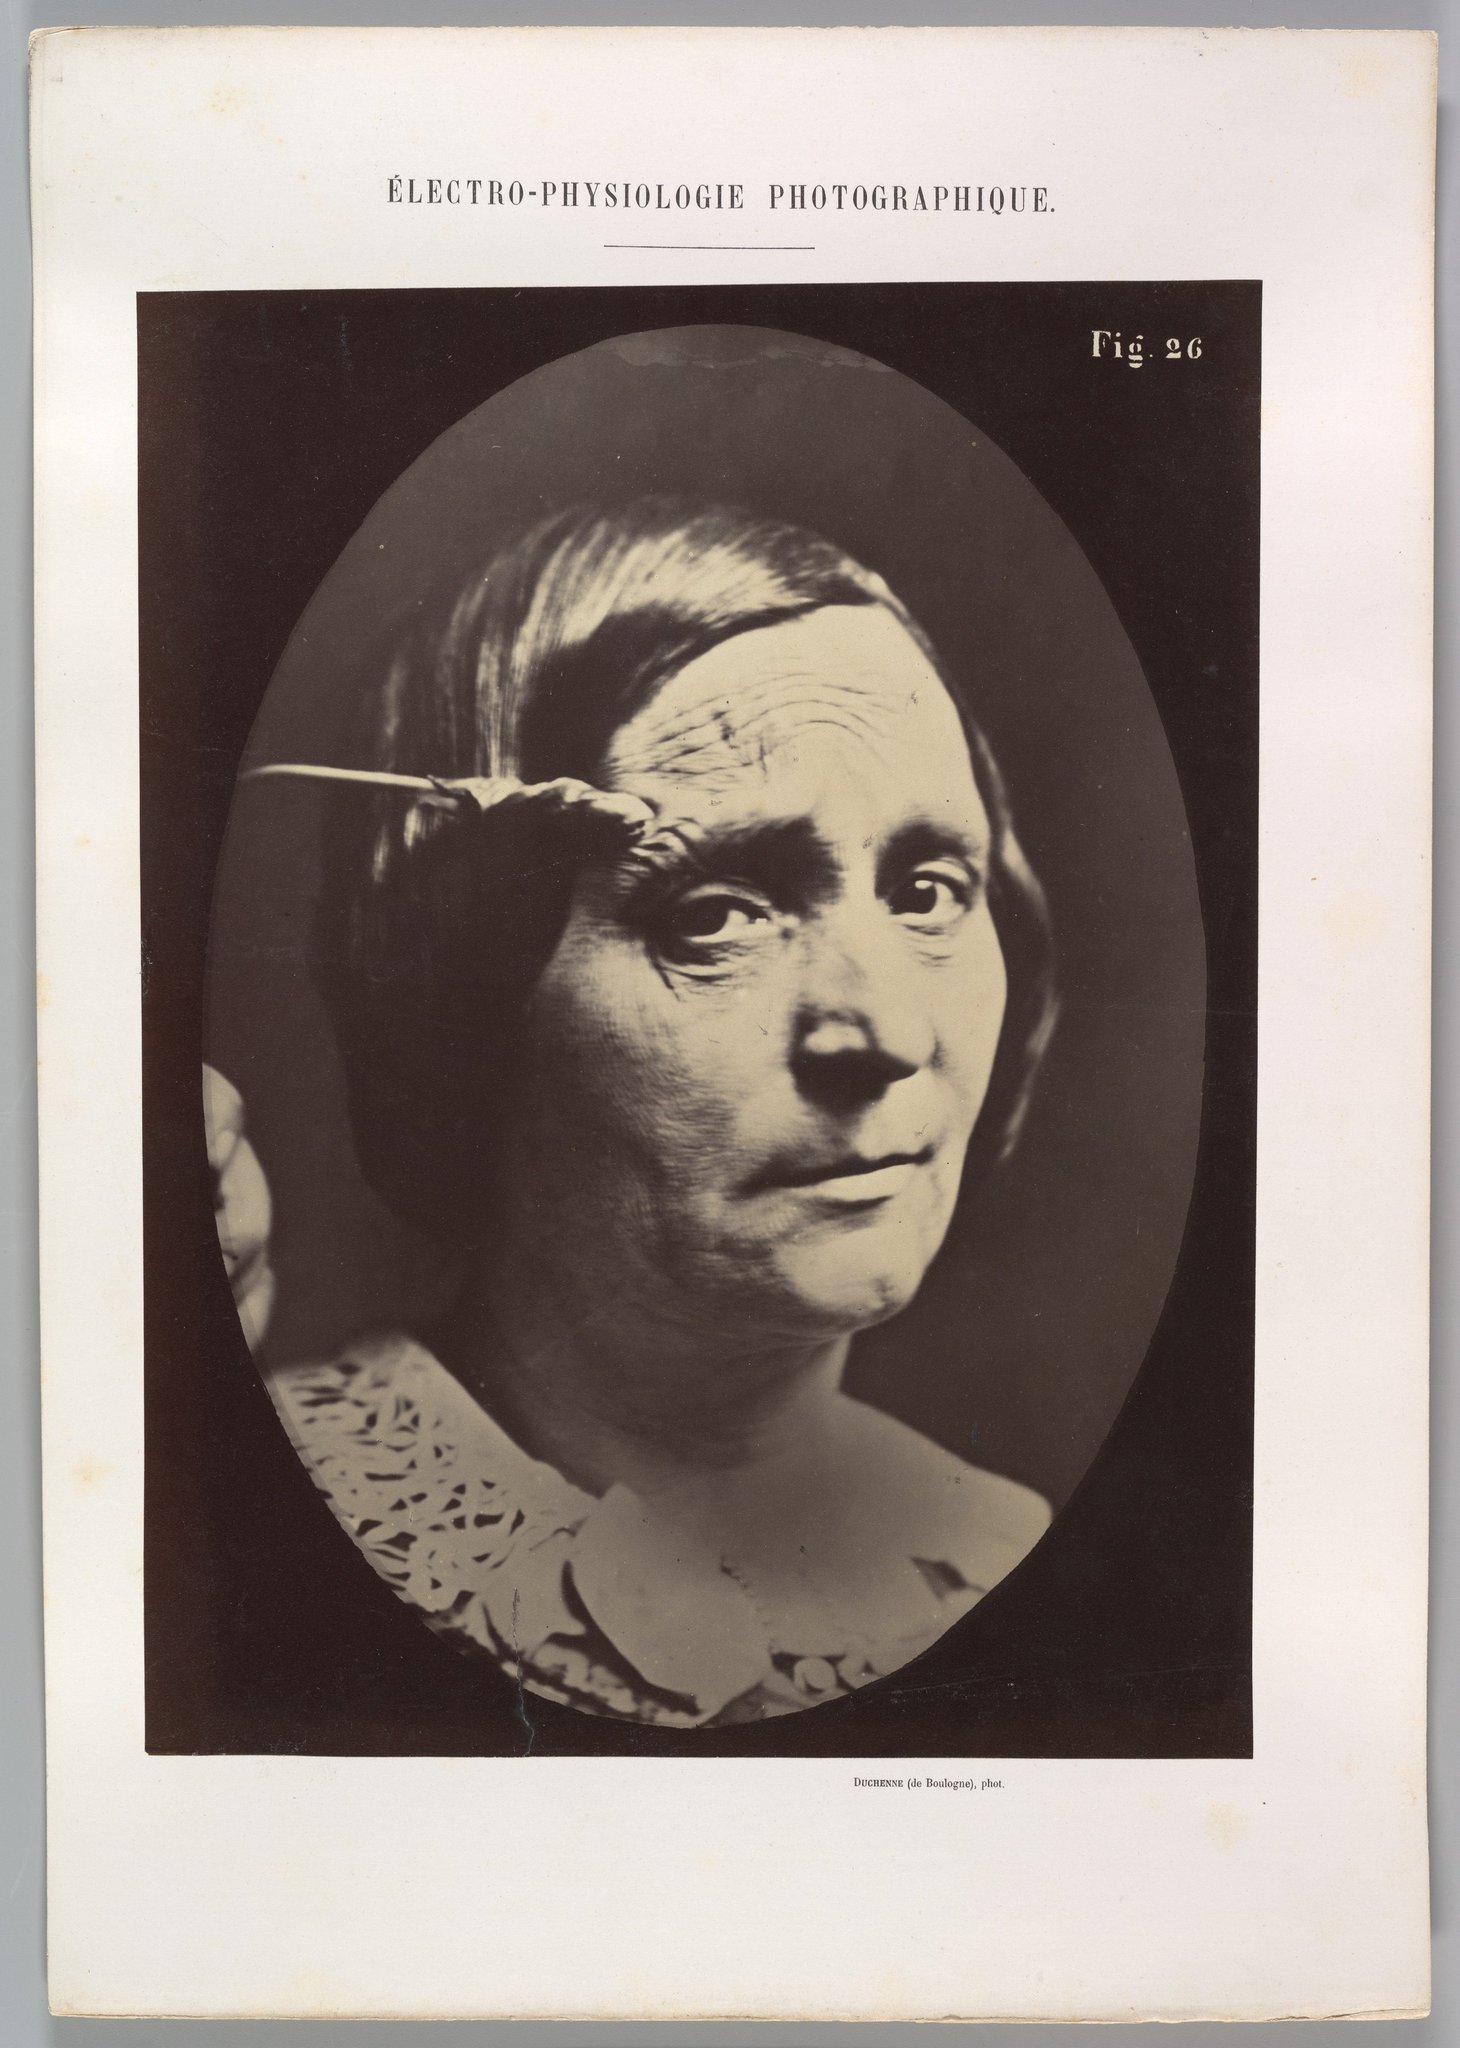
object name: photograph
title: Figure 26: Expression of painful attention and attention, attentive gaze.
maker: guillaume-benjamin-amand duchenne de boulogne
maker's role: artist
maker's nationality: french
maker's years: 1806-1875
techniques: albumen silver print, glass negative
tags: science,portraits,women